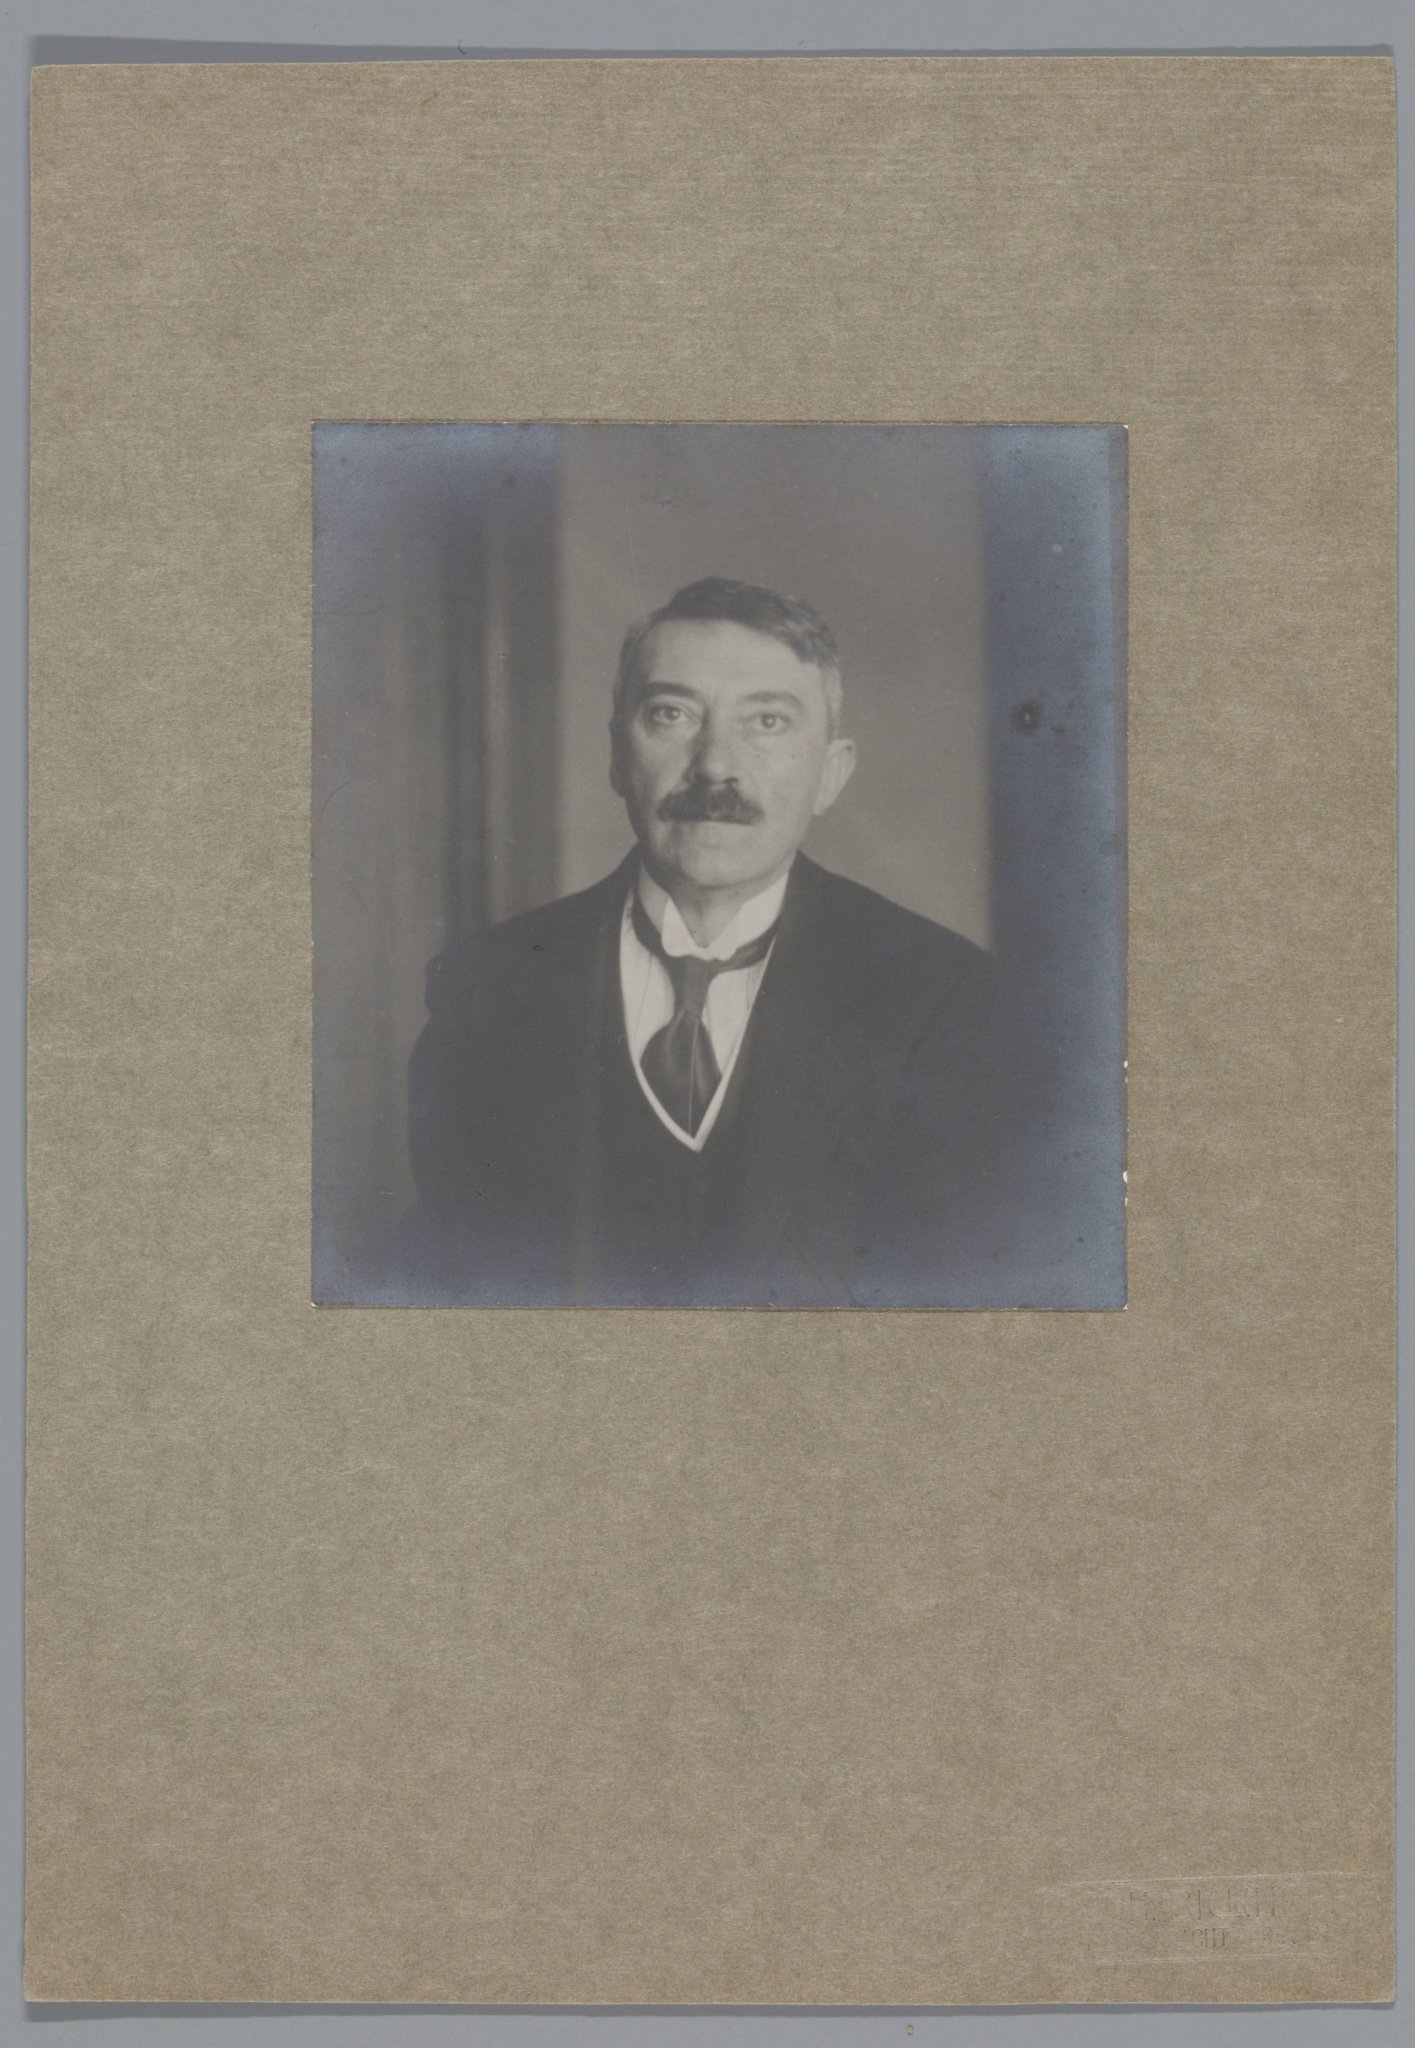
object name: photograph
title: Willem Witsen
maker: johan bickhoff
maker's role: fotograaf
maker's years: 1881-1968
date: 1860-1915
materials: paper, photographic support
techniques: gelatin silver print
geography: amsterdam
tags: painter, print maker, draughtsman, willem witsen